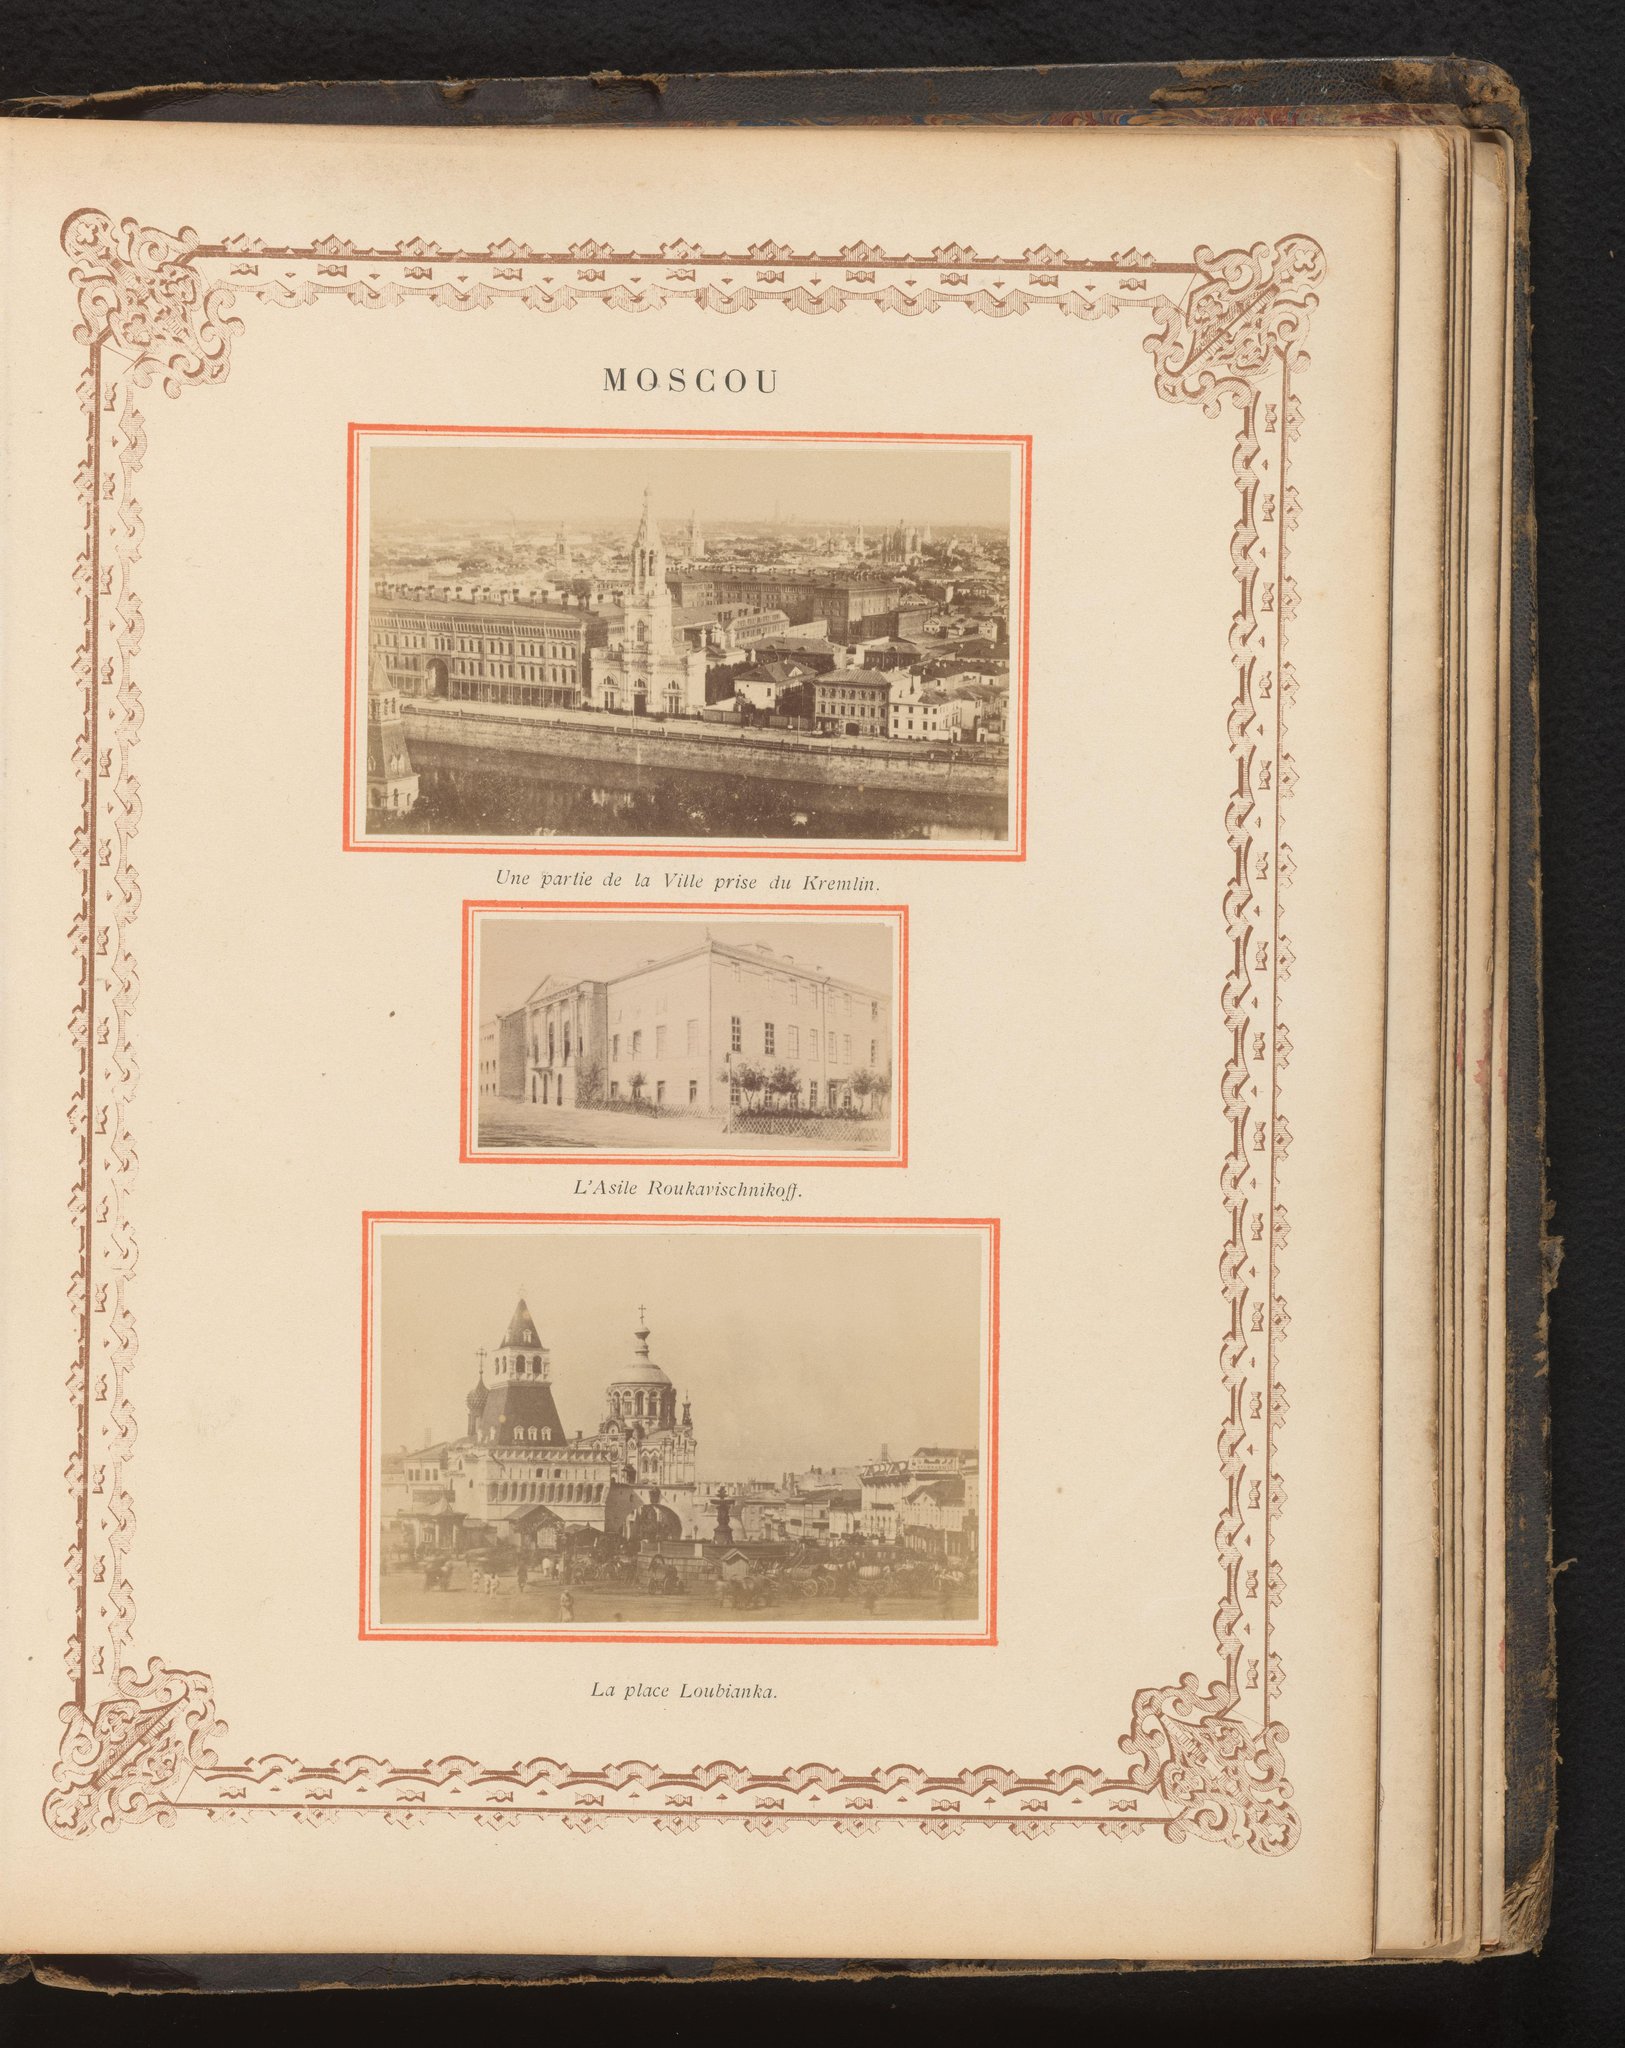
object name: page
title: Gezicht op Moskou, gezicht op het asiel Roukavischnikoff en een gezicht op de Loebjanka gevangenis in Moskou, Rusland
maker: Anonymous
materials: photographic support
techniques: albumen print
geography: moscow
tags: prison, jail, asylum, sanctuary, prospect of city, town panorama, silhouette of city